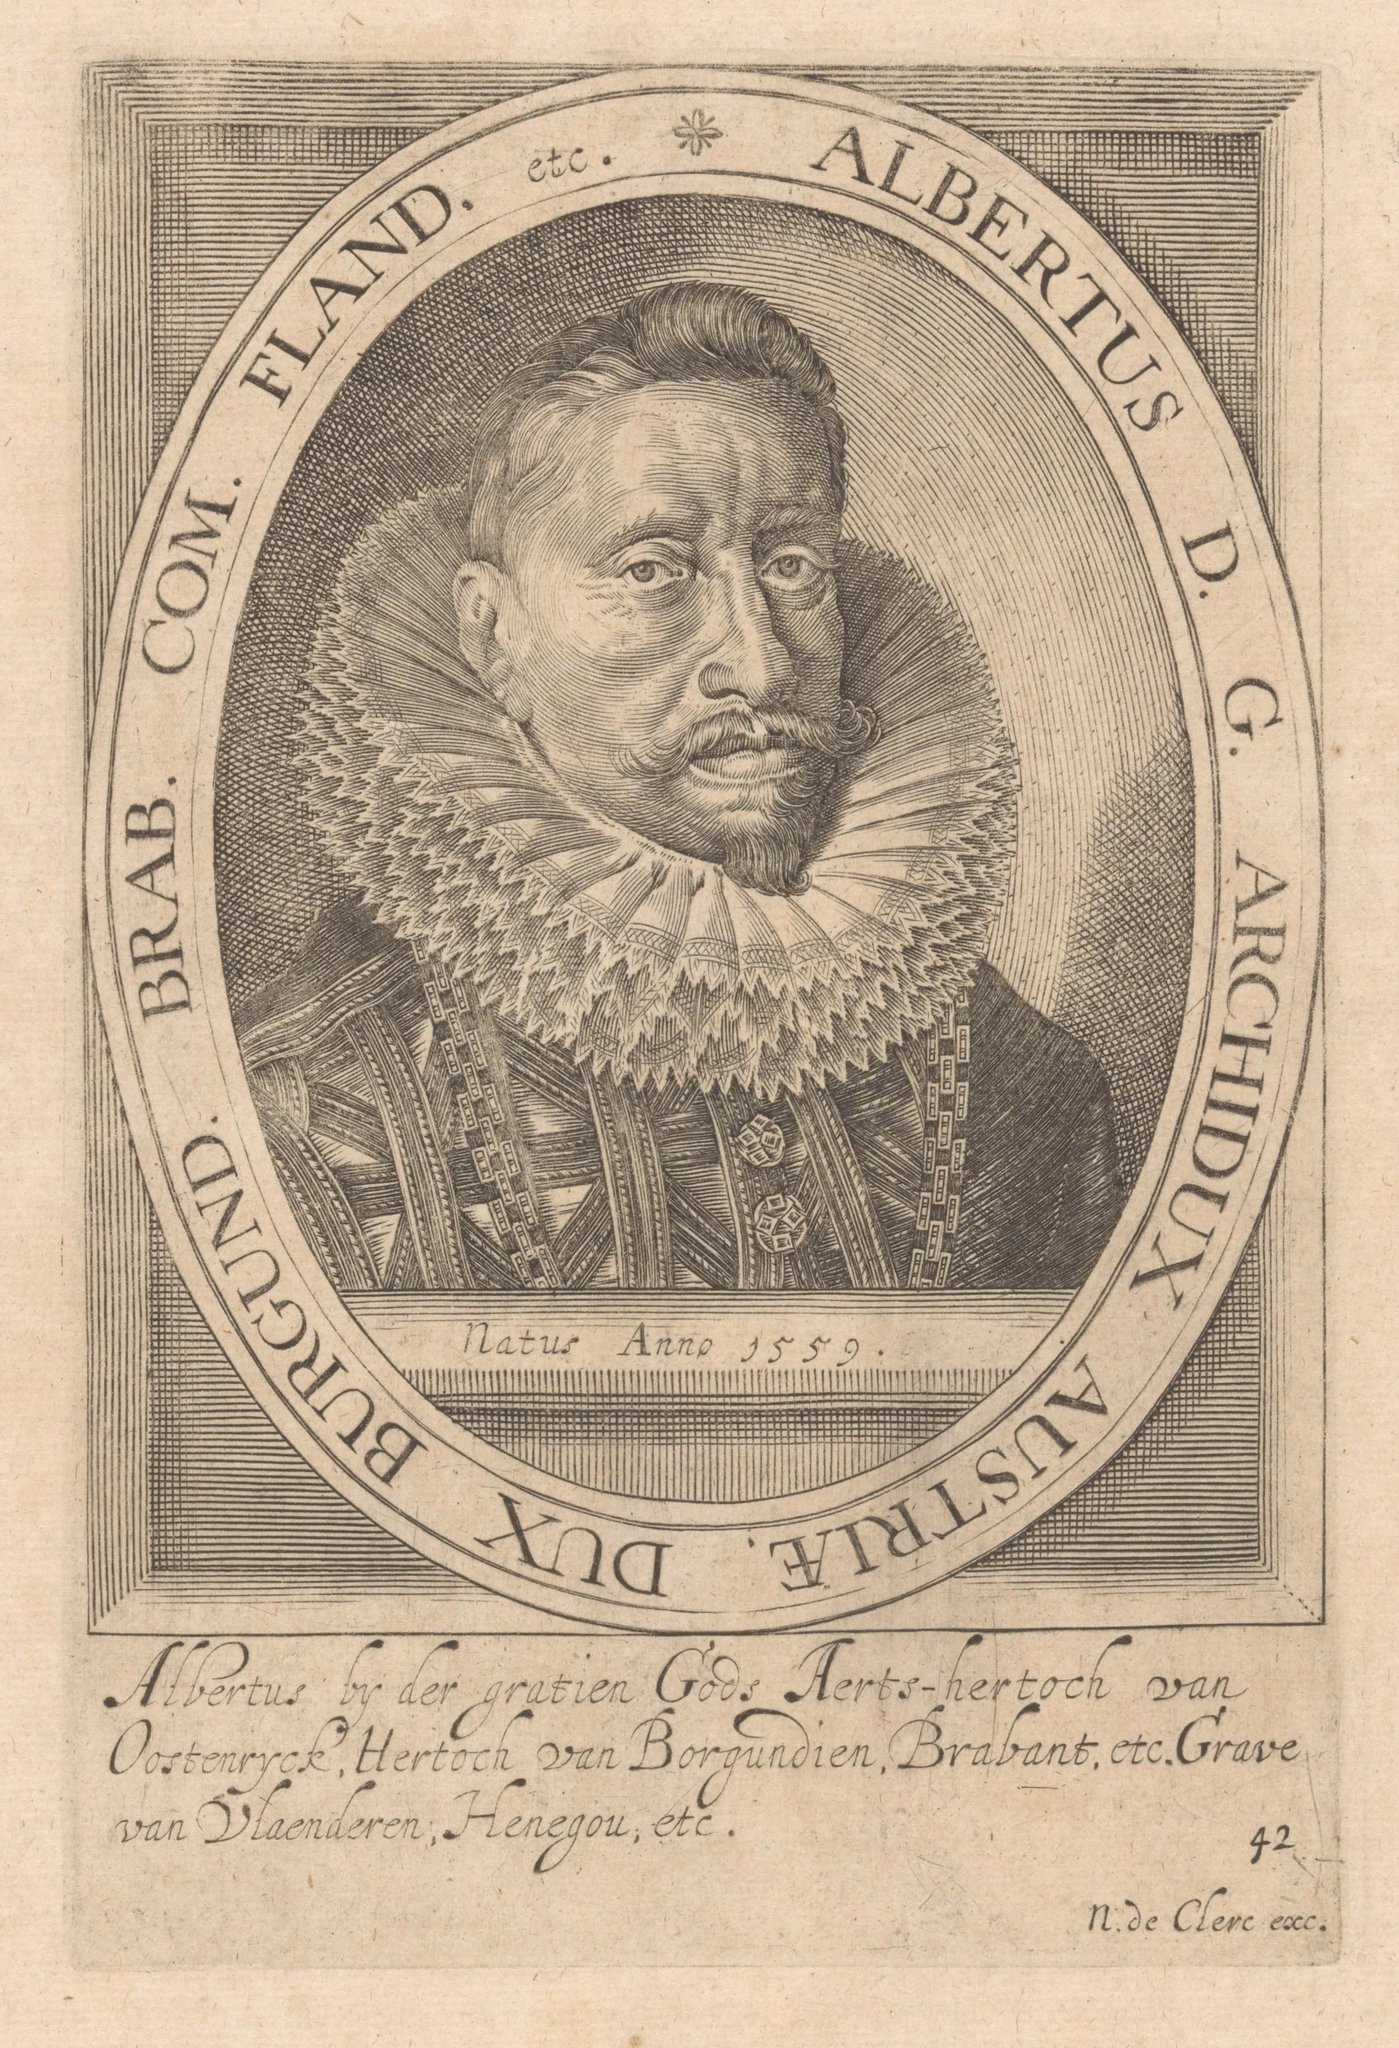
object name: print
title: Portret van Albrecht, aartshertog van Oostenrijk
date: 1599-1623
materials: paper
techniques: engraving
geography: northern netherlands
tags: brussels, albrecht aartshertog van oostenrijk